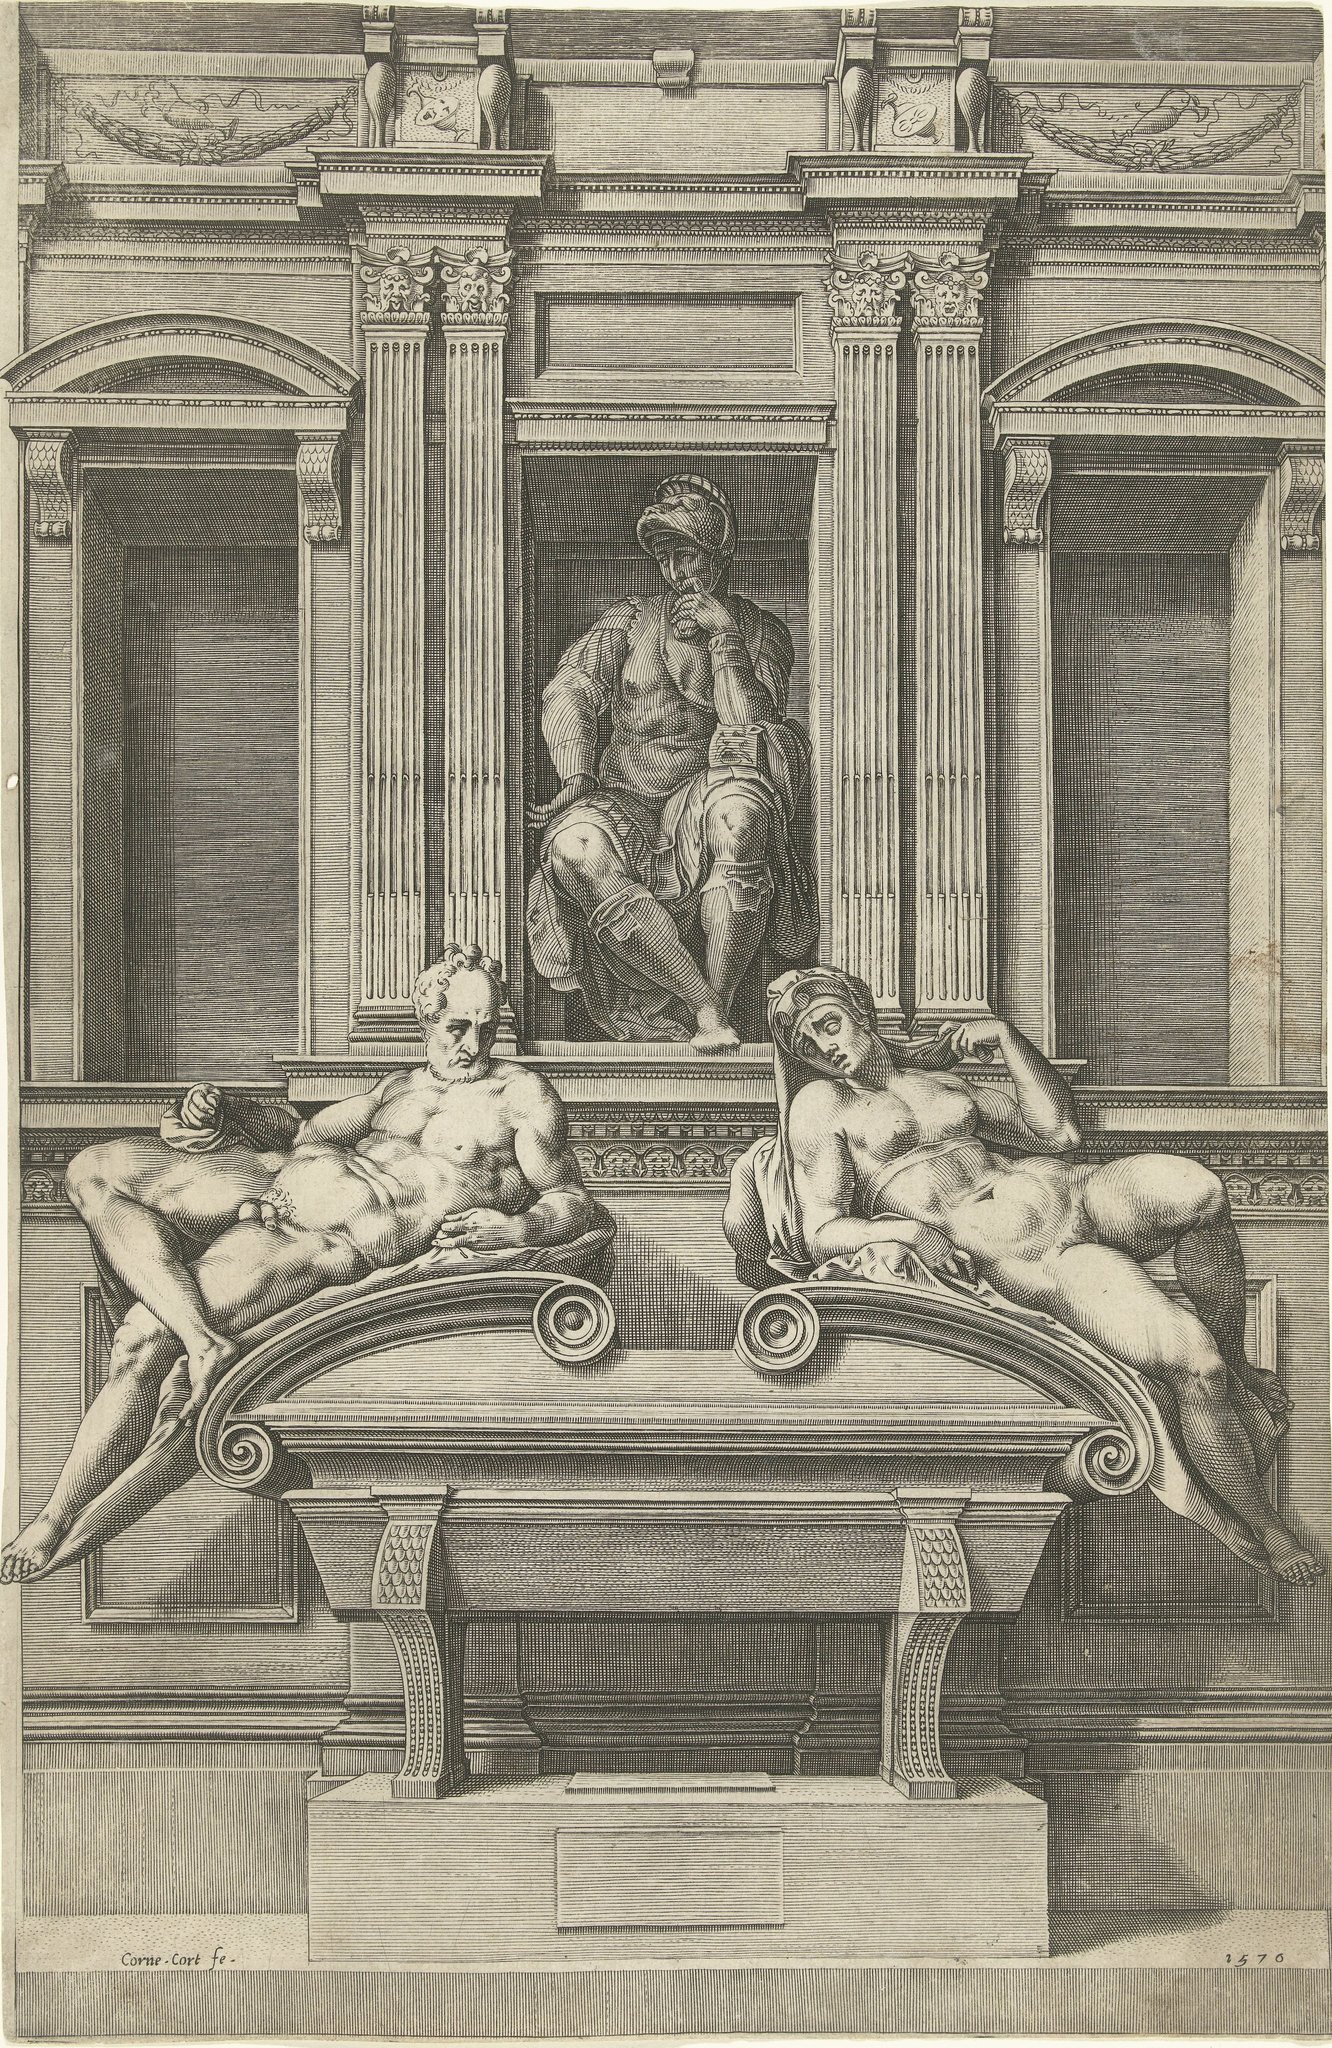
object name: print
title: Tomb of Lorenzo II de’ Medici, Duke of Urbino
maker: cornelis cort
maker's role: print maker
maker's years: 1533-1578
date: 1570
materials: paper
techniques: engraving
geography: rome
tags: grave, tomb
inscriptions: collector's mark: Lugt 2228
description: The tombs of Giuliano and Lorenzo de’ Medici in Florence – created by Michelangelo – rank among the most famous sculptural ensembles of the Italian Renaissance. Drawn or modelled copies of the tombs were frequently made by other artists. Among Van der Schardt’s nine modelli are studies of Lorenzo’s right hand, and of the left and right arm of the recumbent figure at the left, Night. The figure at the right personifies Day.